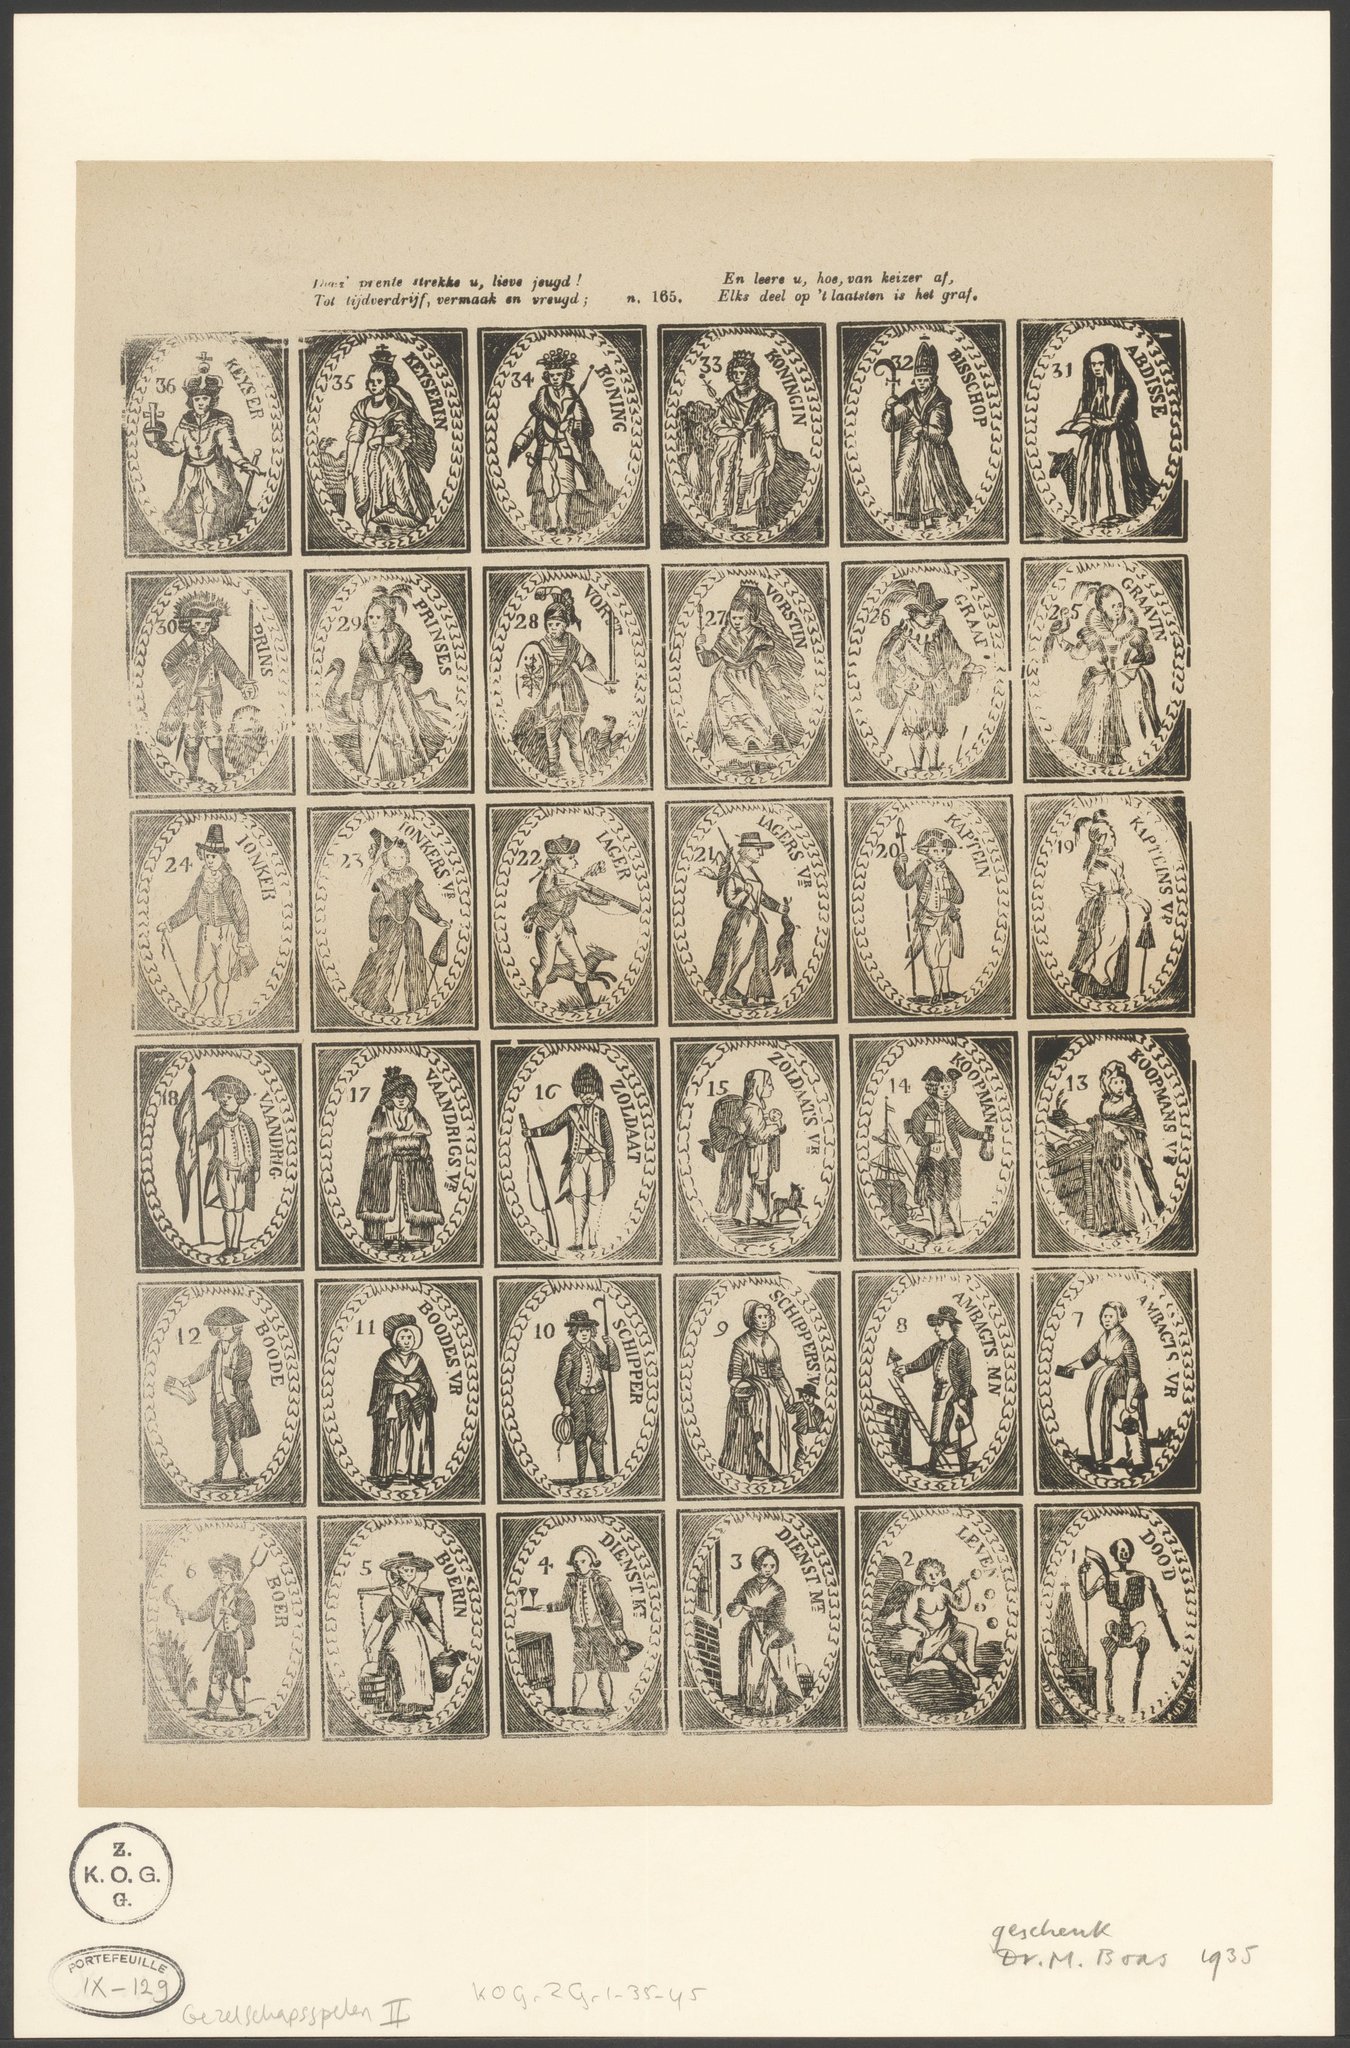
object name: popular print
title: Deez' prente strekke u, lieve jeugd! / Tot tijdverdrijf, vermaak en vreugd; / En leere u, hoe, van keizer af, / Elke deel op 't laatsten is het graf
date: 1833-1900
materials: paper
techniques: letterpress printing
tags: social position, playing-cards, nobility and patriciate; chivalry, knighthood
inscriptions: stamp, collector's mark: Lugt 1641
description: Blad met 36 speelkaarten (floskaartjes) met voorstellingen van verschillende figuren. De afbeeldingen vormen achttien paren, aflopend genummerd van bovenaan links nummer 36 tot onderaan rechts nummer 1. Op de twee laagste nummers na tonen ze zeventien koppels, man en vrouw, met de man net één nummer hoger dan de vrouw, waarbij elk paar een beroep of een maatschappelijke positie voorstelt. Genummerd midden boven: n. 165. Onderwerpsrubrieken binnen de Atlas Zeden en Gewoonten: Zeden en gewoonten in engeren zin, Spel en vermaak, Gezelschapsspel II, Ganzenbord en dergelijke.